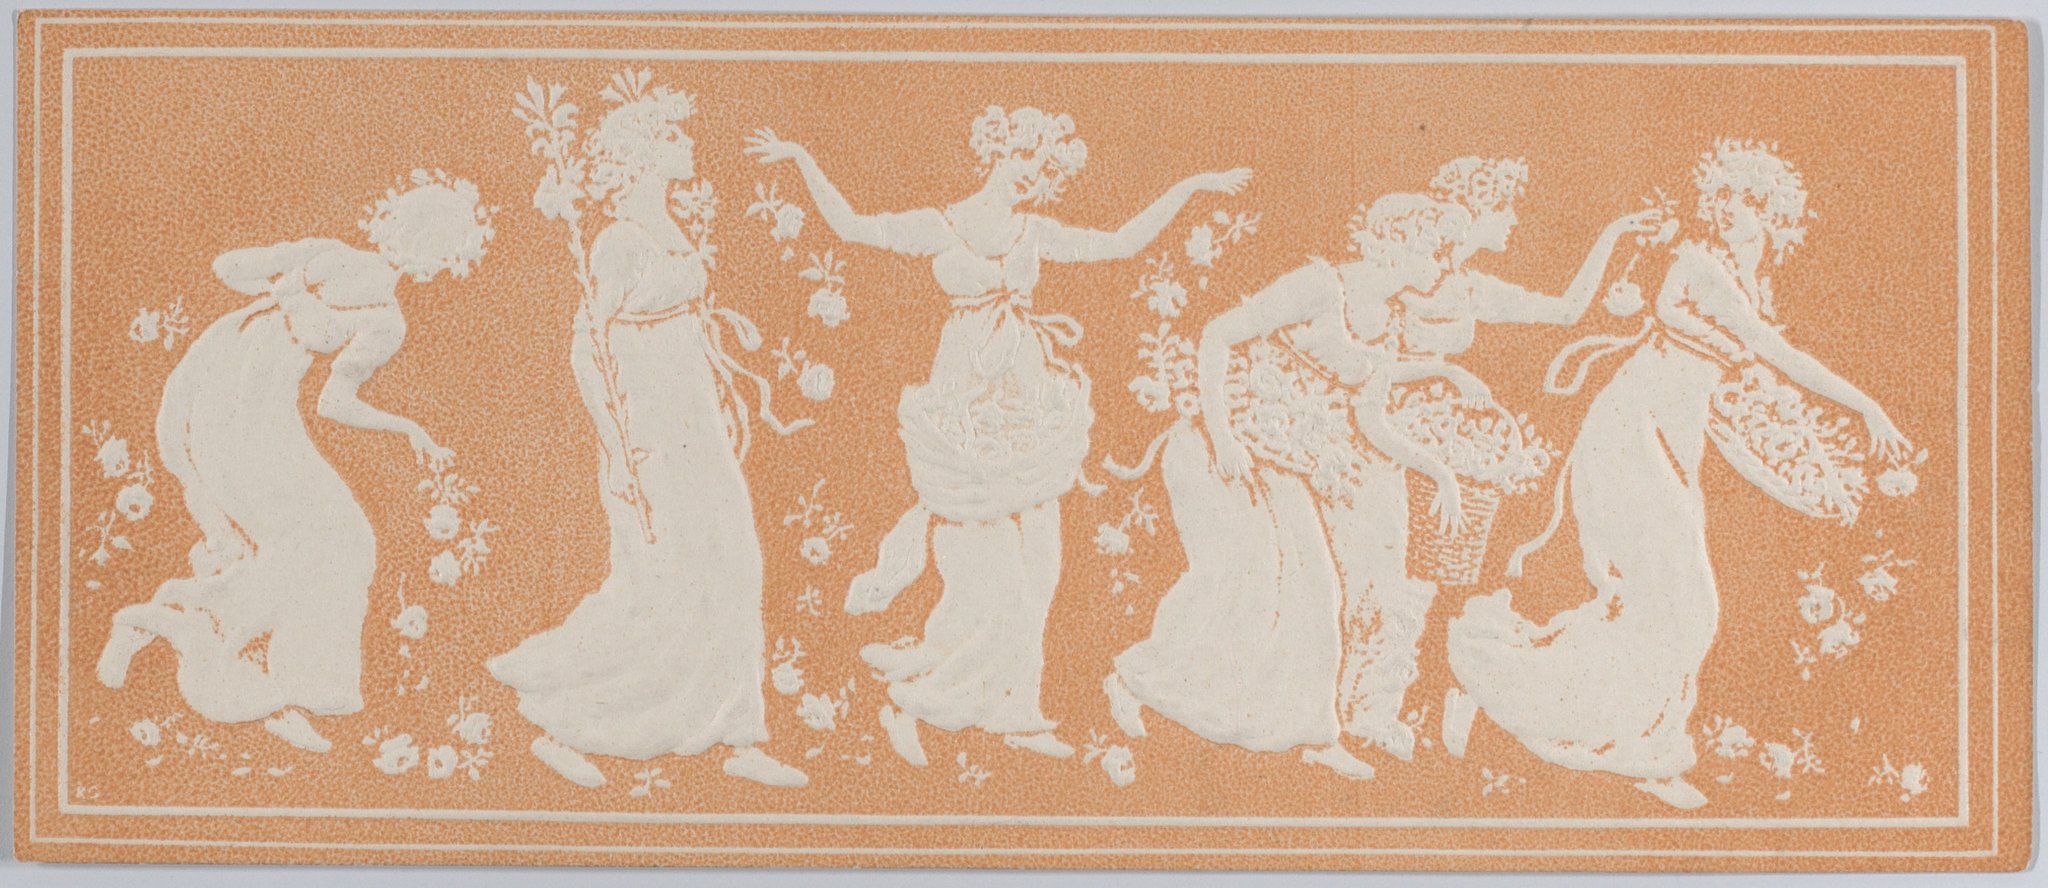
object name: valentine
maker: kate greenaway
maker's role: artist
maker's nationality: british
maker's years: 1846-1901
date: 1880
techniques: printing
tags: boys,girls